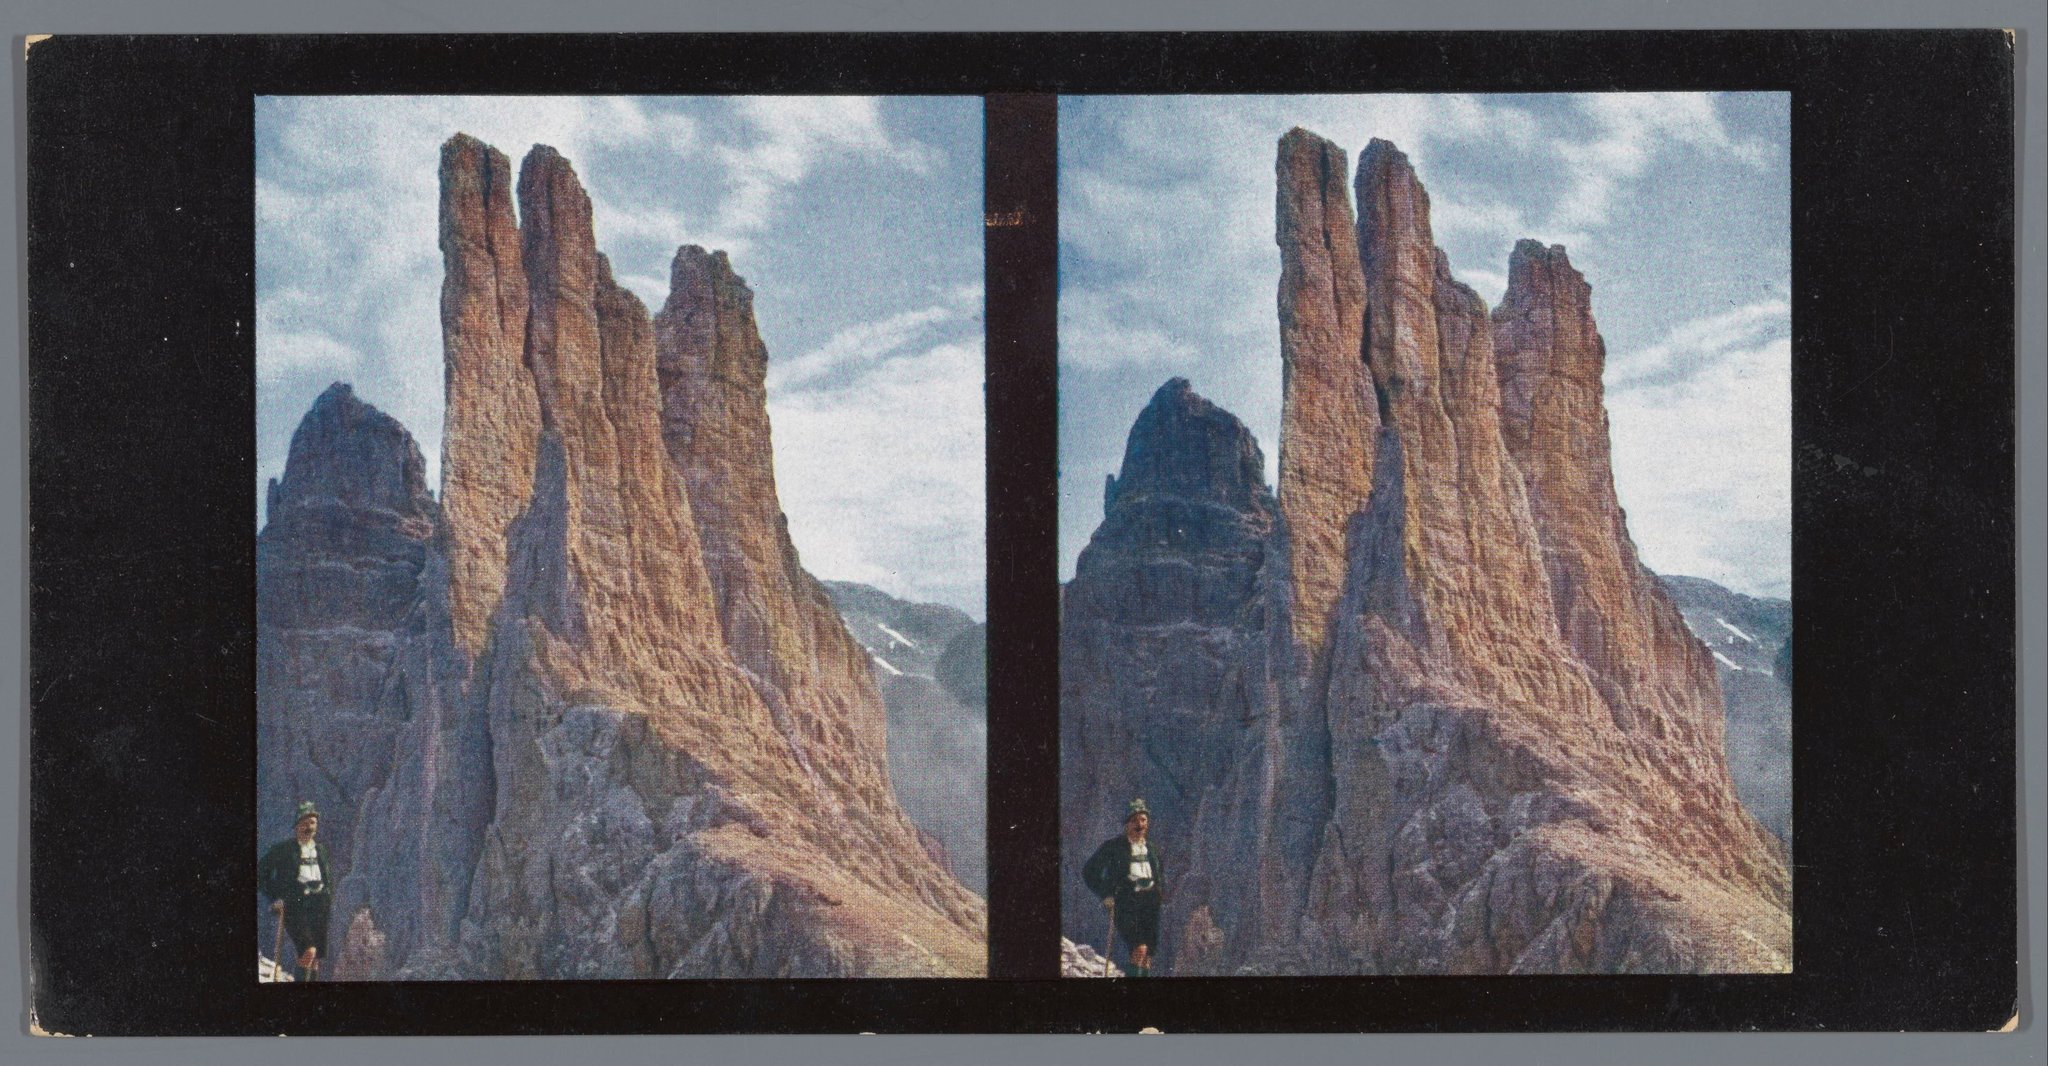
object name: stereograph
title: Vajolet-Türme.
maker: hans hildenbrand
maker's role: fotograaf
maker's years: 1870-1957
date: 1902-1908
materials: cardboard, ink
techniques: color autotype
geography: dolomites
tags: mountains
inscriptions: inscription: ‘Beste Wirkung bei Betrachtung durch das ,,Isostereo''.’, number: ‘Nr. 28.’, inscription: ‘,,Chromoplast''-Bild.’, inscription: ‘D. R. G. M. Nr. 437 756.’, inscription: ‘Warenzeichen 142 123.’